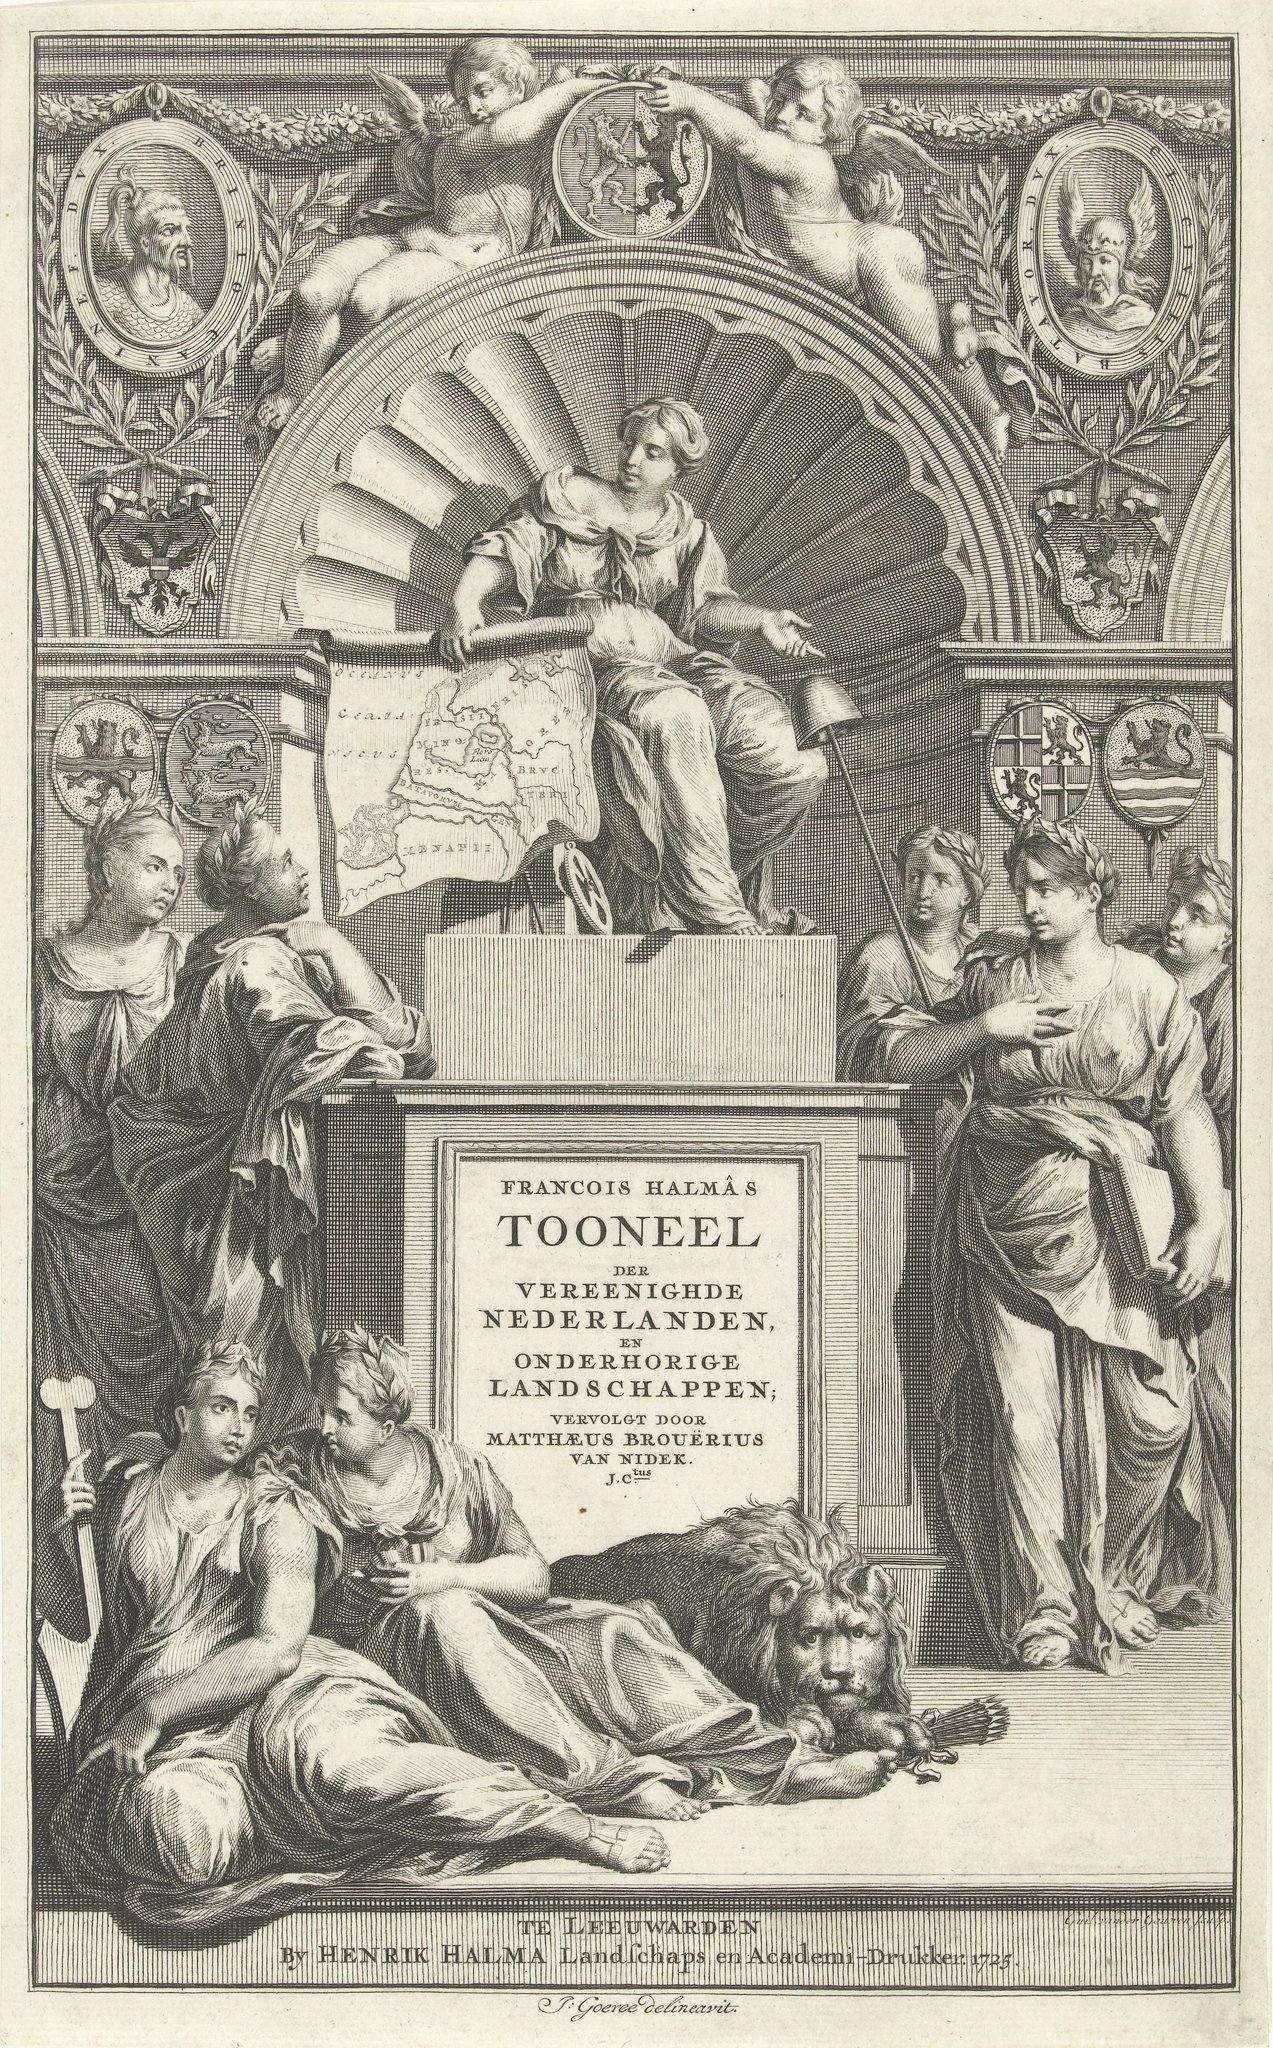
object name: print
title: Allegorie van de Republiek der zeven verenigde Nederlanden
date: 1725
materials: paper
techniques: engraving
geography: amsterdam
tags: printer, publisher, françois halma, coat of arms (as symbol of the state, etc.), personifications of countries, nations, states, districts, etc., beasts of prey, predatory animals: lion (+ animals used symbolically), netherlands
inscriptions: collector's mark: Lugt 2228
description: Titelpagina met allegorische voorstelling. De personificatie van het land zit op een verhoogde troon, omringd door de personificaties van de zeven provincies. Ze houdt een kaart van de Nederlanden in de hand. Op de troon de titel van het boekwerk. Onder de troon de nederlandse leeuw, met in zijn klauwen een bundel pijlen.